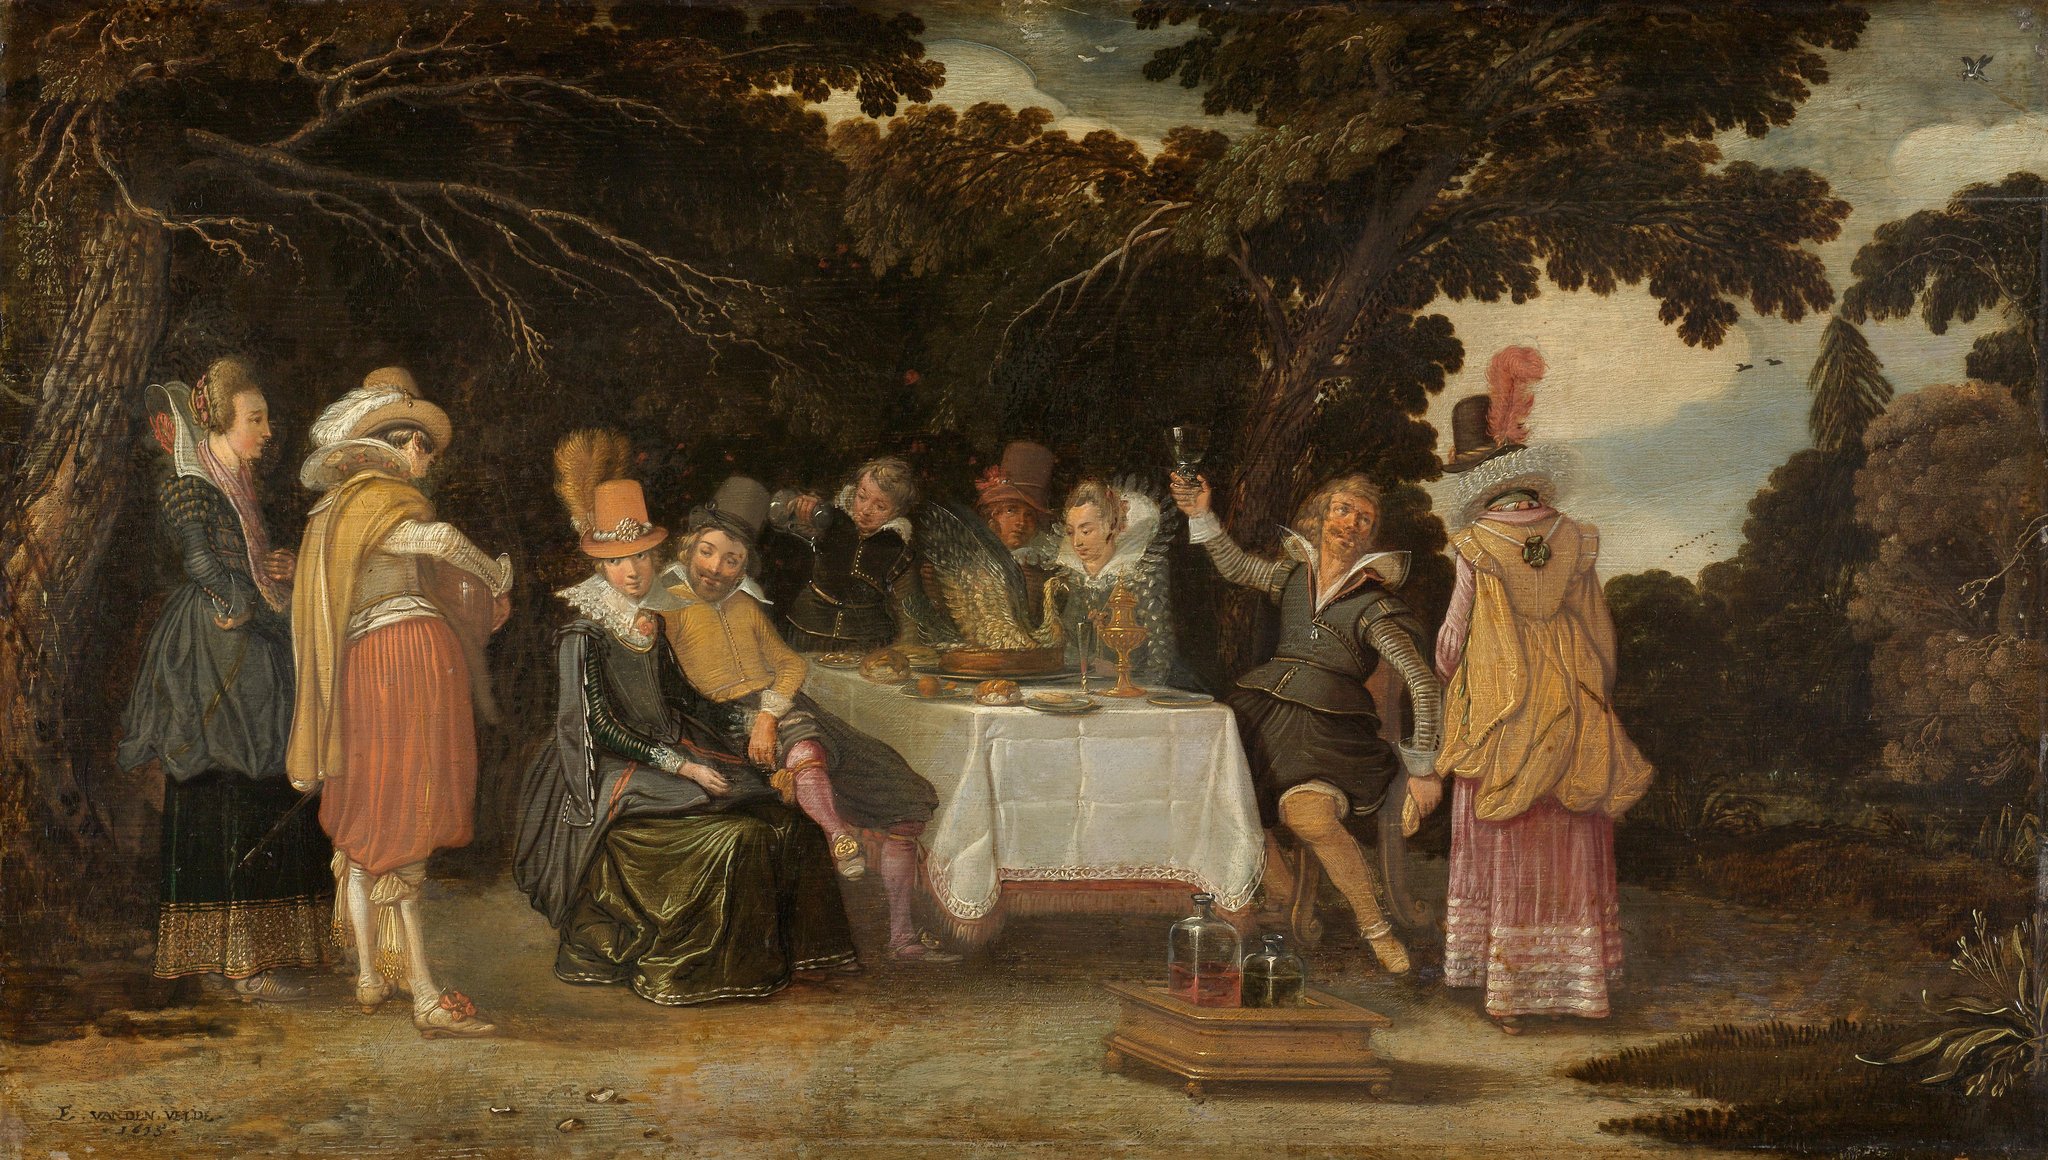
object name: painting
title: An open-air Party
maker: esaias van de velde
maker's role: draughtsman, painter, print maker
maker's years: 1587-1630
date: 1615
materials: oil, panel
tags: instrumental and vocal music together - cc - out of doors, courting, banquet of elegant company - cc - out of doors, lute, and special forms of lute, e.g.: theorbo - cc - out of doors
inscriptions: signature and date, lower left: ‘E. VANDEN.VELDE. / .1615.’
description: De buitenpartij. Een elegant gezelschap zittend aan een tafel onder bomen in een tuin of park. Links speelt een man op de luit terwijl een vrouw zingt. Op tafel staat een pastei met een pauw, borden en glazen, een bediende schenkt wijn. Op de voorgrond staat een wijnkoeler met enkele flessen.